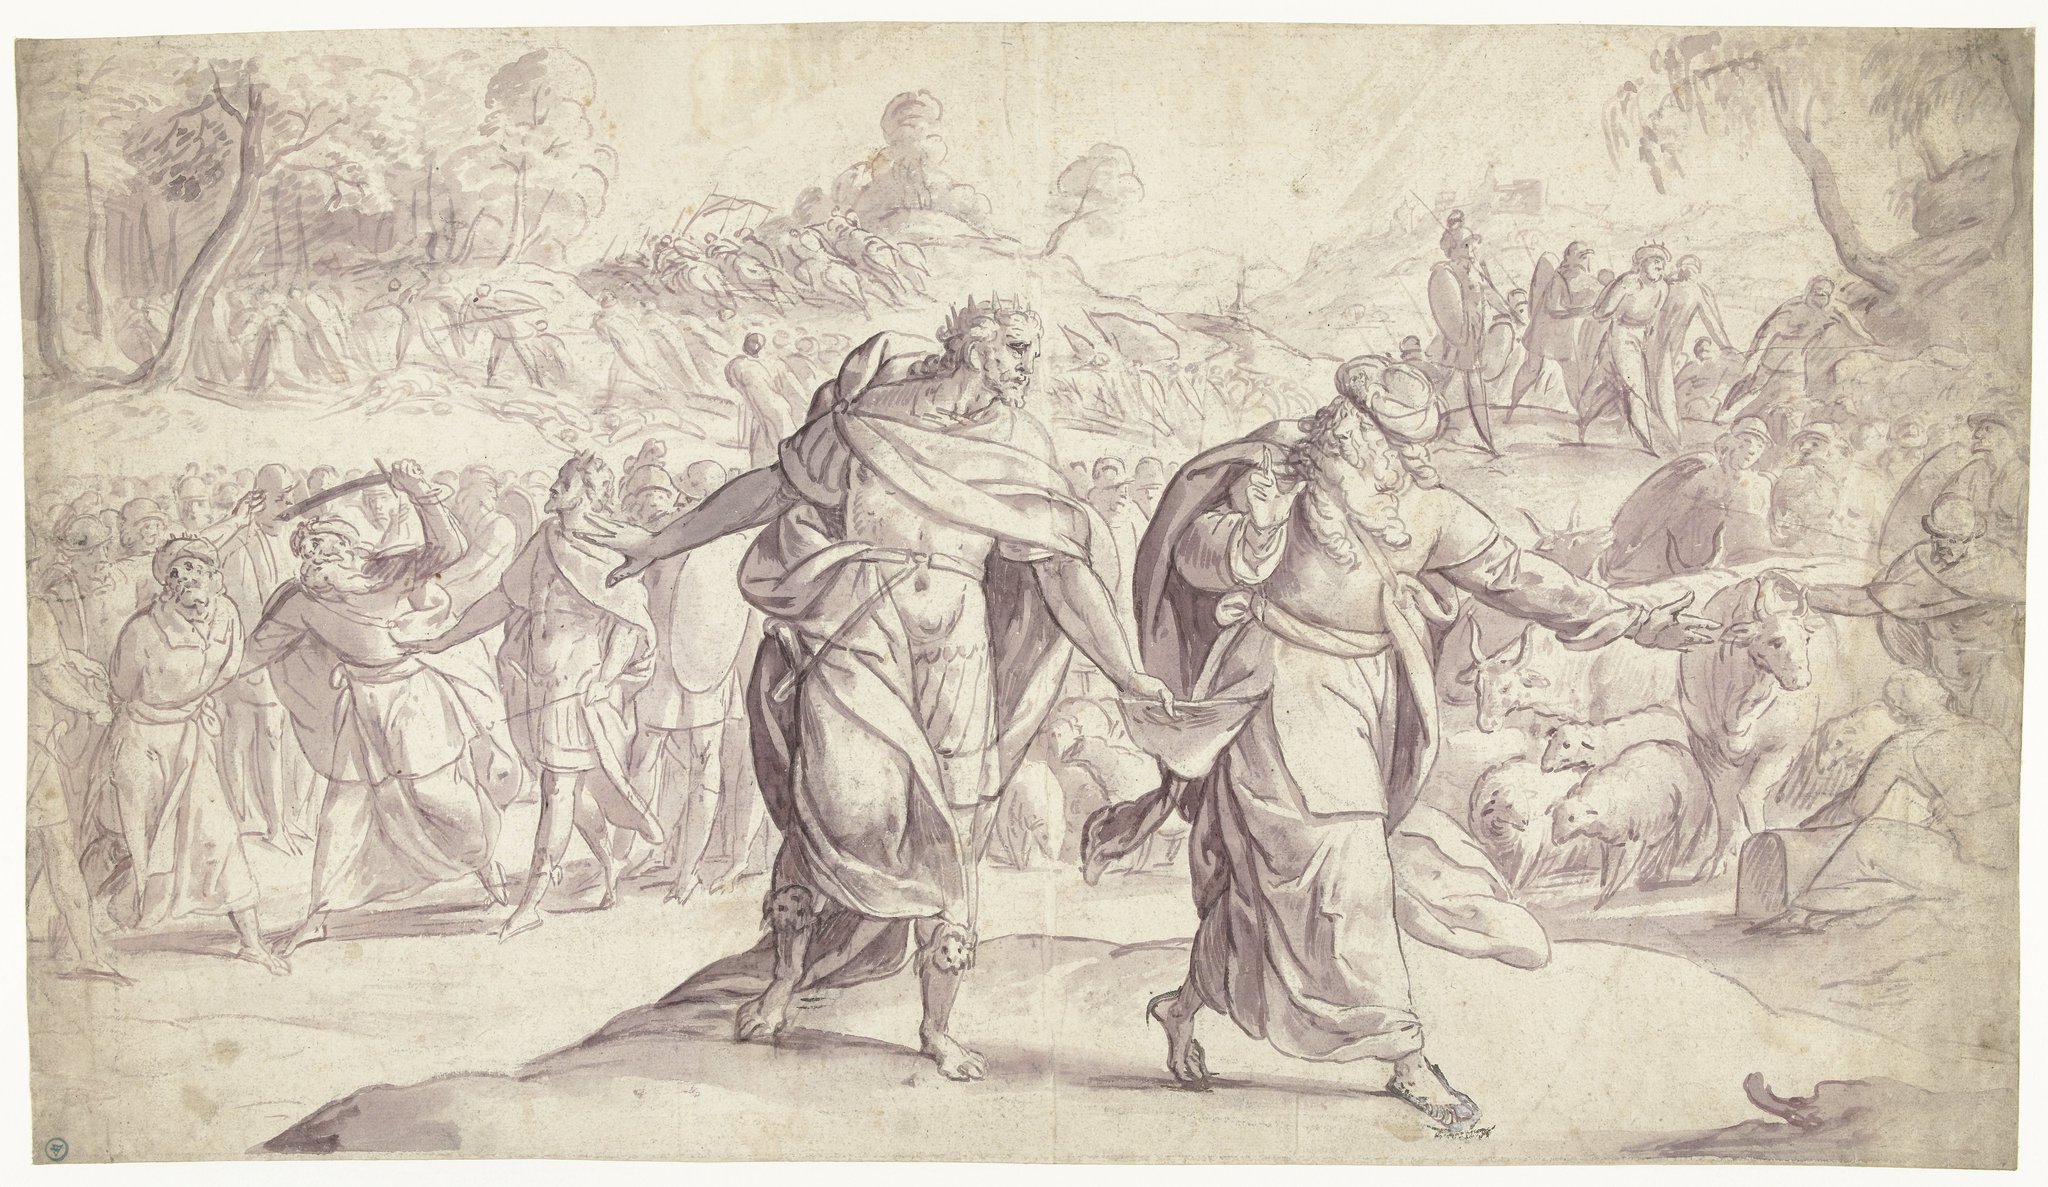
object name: drawing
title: Historie van Jozua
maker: frans francken (i)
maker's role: draughtsman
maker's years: 1542-1616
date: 1552-1616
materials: ink, paper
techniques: brush, pen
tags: the five amorite kings are killed either on joshua's command or by his own hand, and their bodies are hanged as a display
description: Op de voorgrond grijpt Jozua een oude man bij de mantel (één van de leiders). Links op de achtergrond geeft hij het bevel om vijf koningen terechttestellen (Jozua 10:26). Mogelijk een ontwerp voor een wandtapijt.